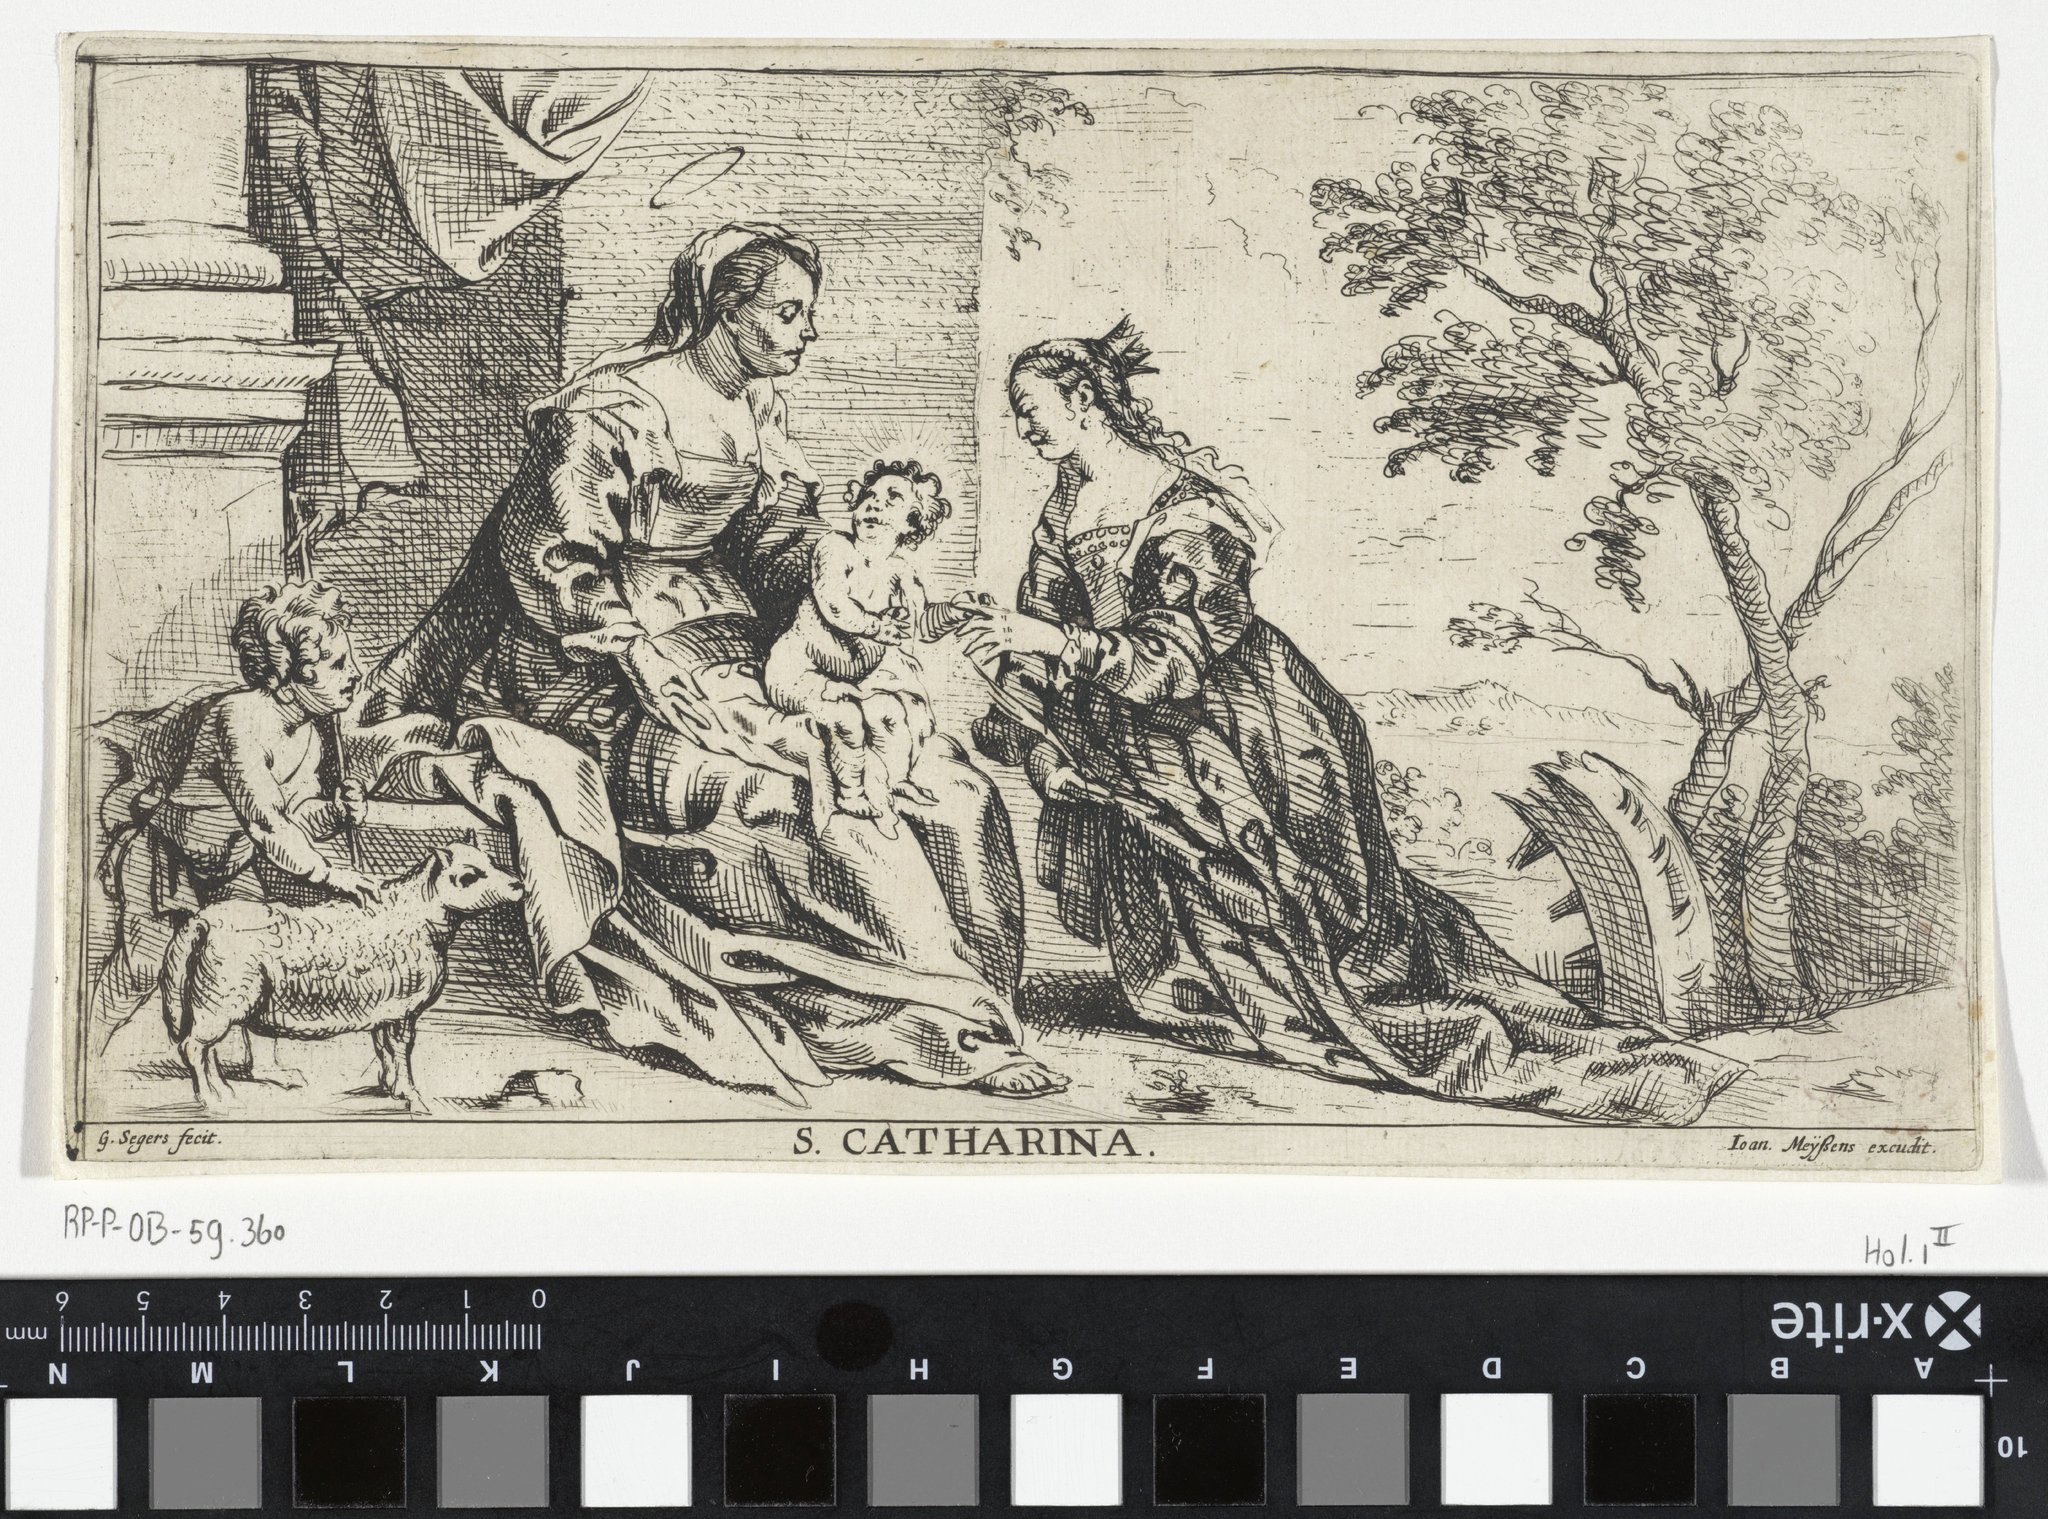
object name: print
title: S. Catharina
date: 1591-1651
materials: paper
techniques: etching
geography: antwerp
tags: john the baptist as child ~ madonna-representations (n.b. secondary notation only), the mystic marriage of st. catherine of alexandria with the infant christ: the christ-child puts a ring on her finger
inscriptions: collector's mark: Lugt 240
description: De heilige Catharina van Alexandrië zit geknield voor het Christuskind, aan haar voeten het gebroken rad. Het Christuskind zit bij Maria op schoot, hij schuift een ring om de vinger van Catharina. Links de jonge Johannes de Doper met het lam.